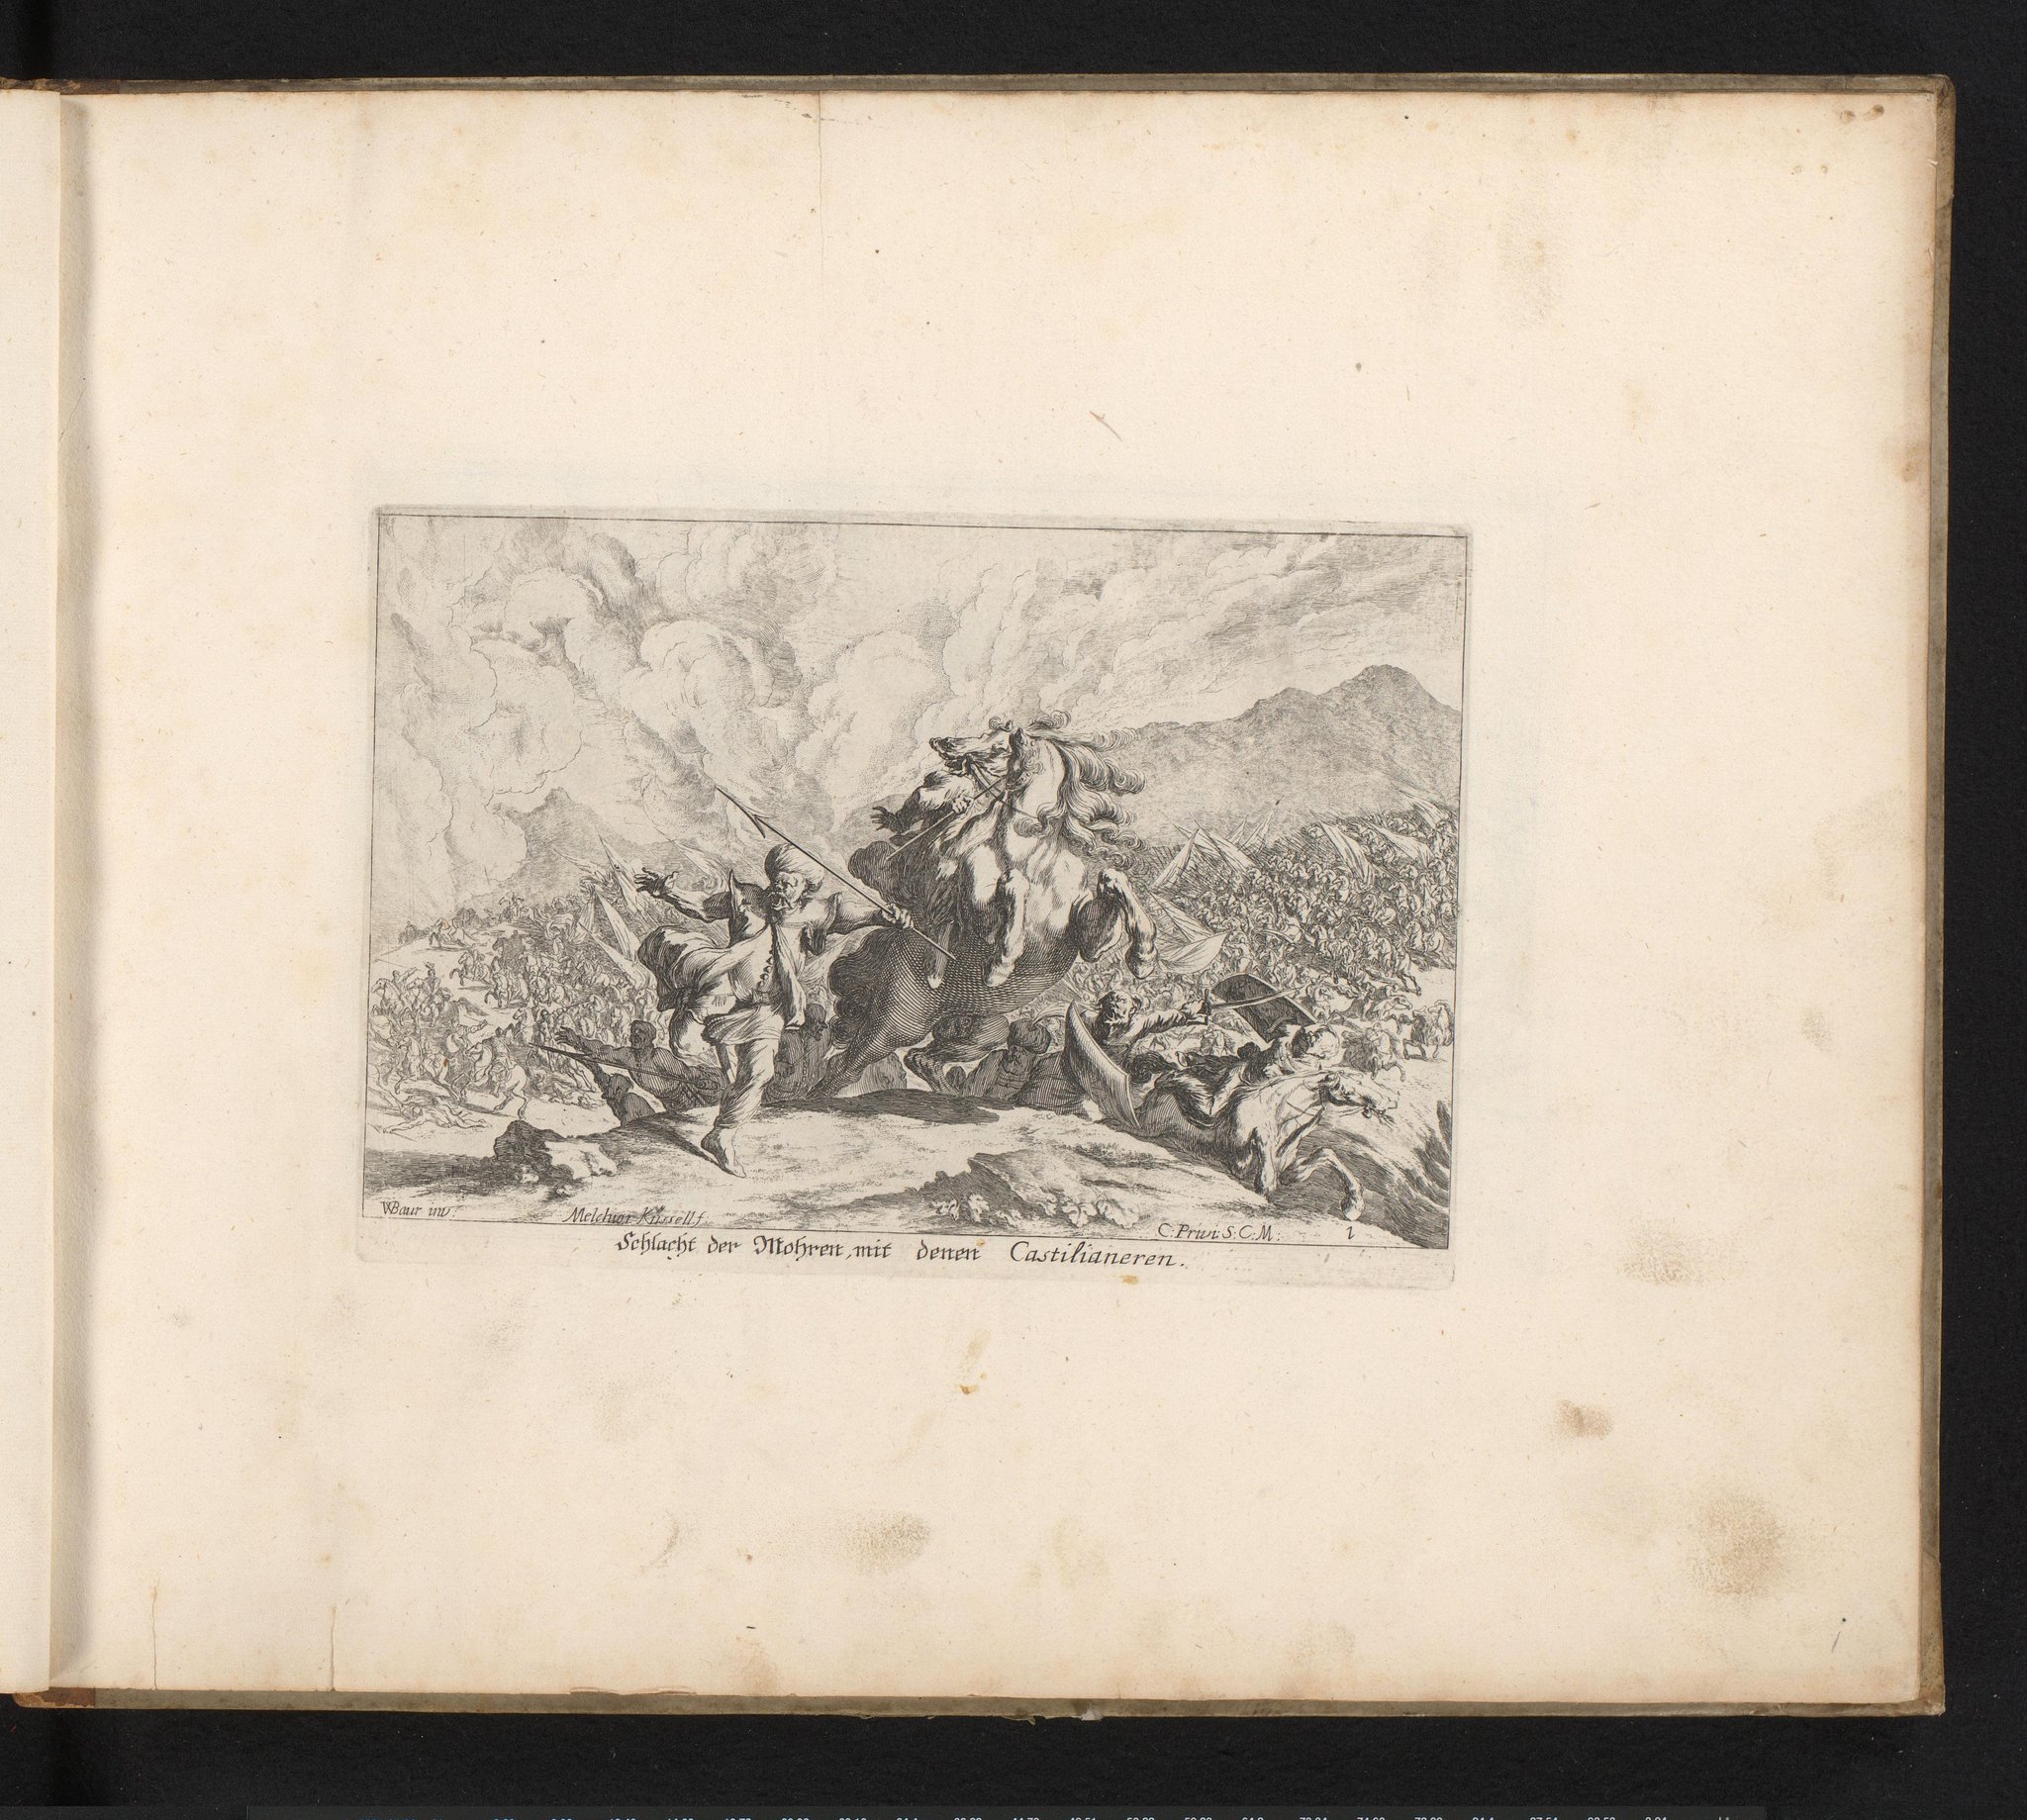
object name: print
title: Gevecht tussen de Moren en Castilianen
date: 1670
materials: paper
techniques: etching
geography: augsburg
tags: battle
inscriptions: collector's mark: Lugt 2228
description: Tekst in het Duits in de ondermarge. Rechtsonder genummerd: 1. Prent maakt deel uit van een album.